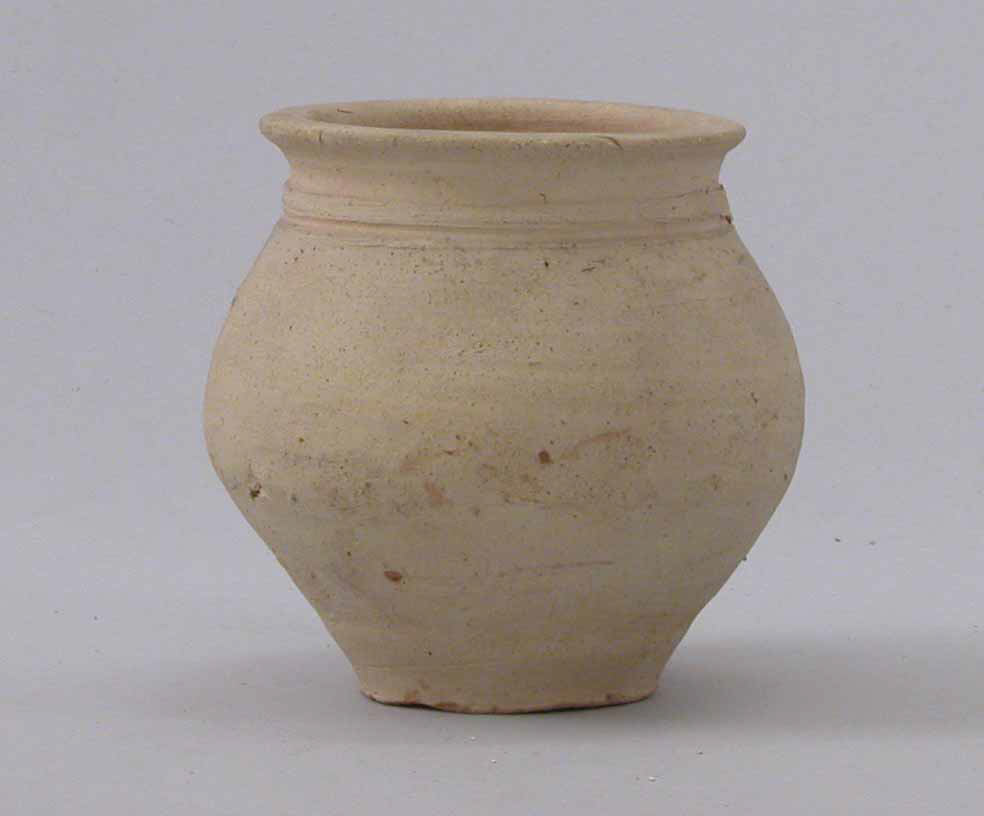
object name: jar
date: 767-900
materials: earthenware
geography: iran